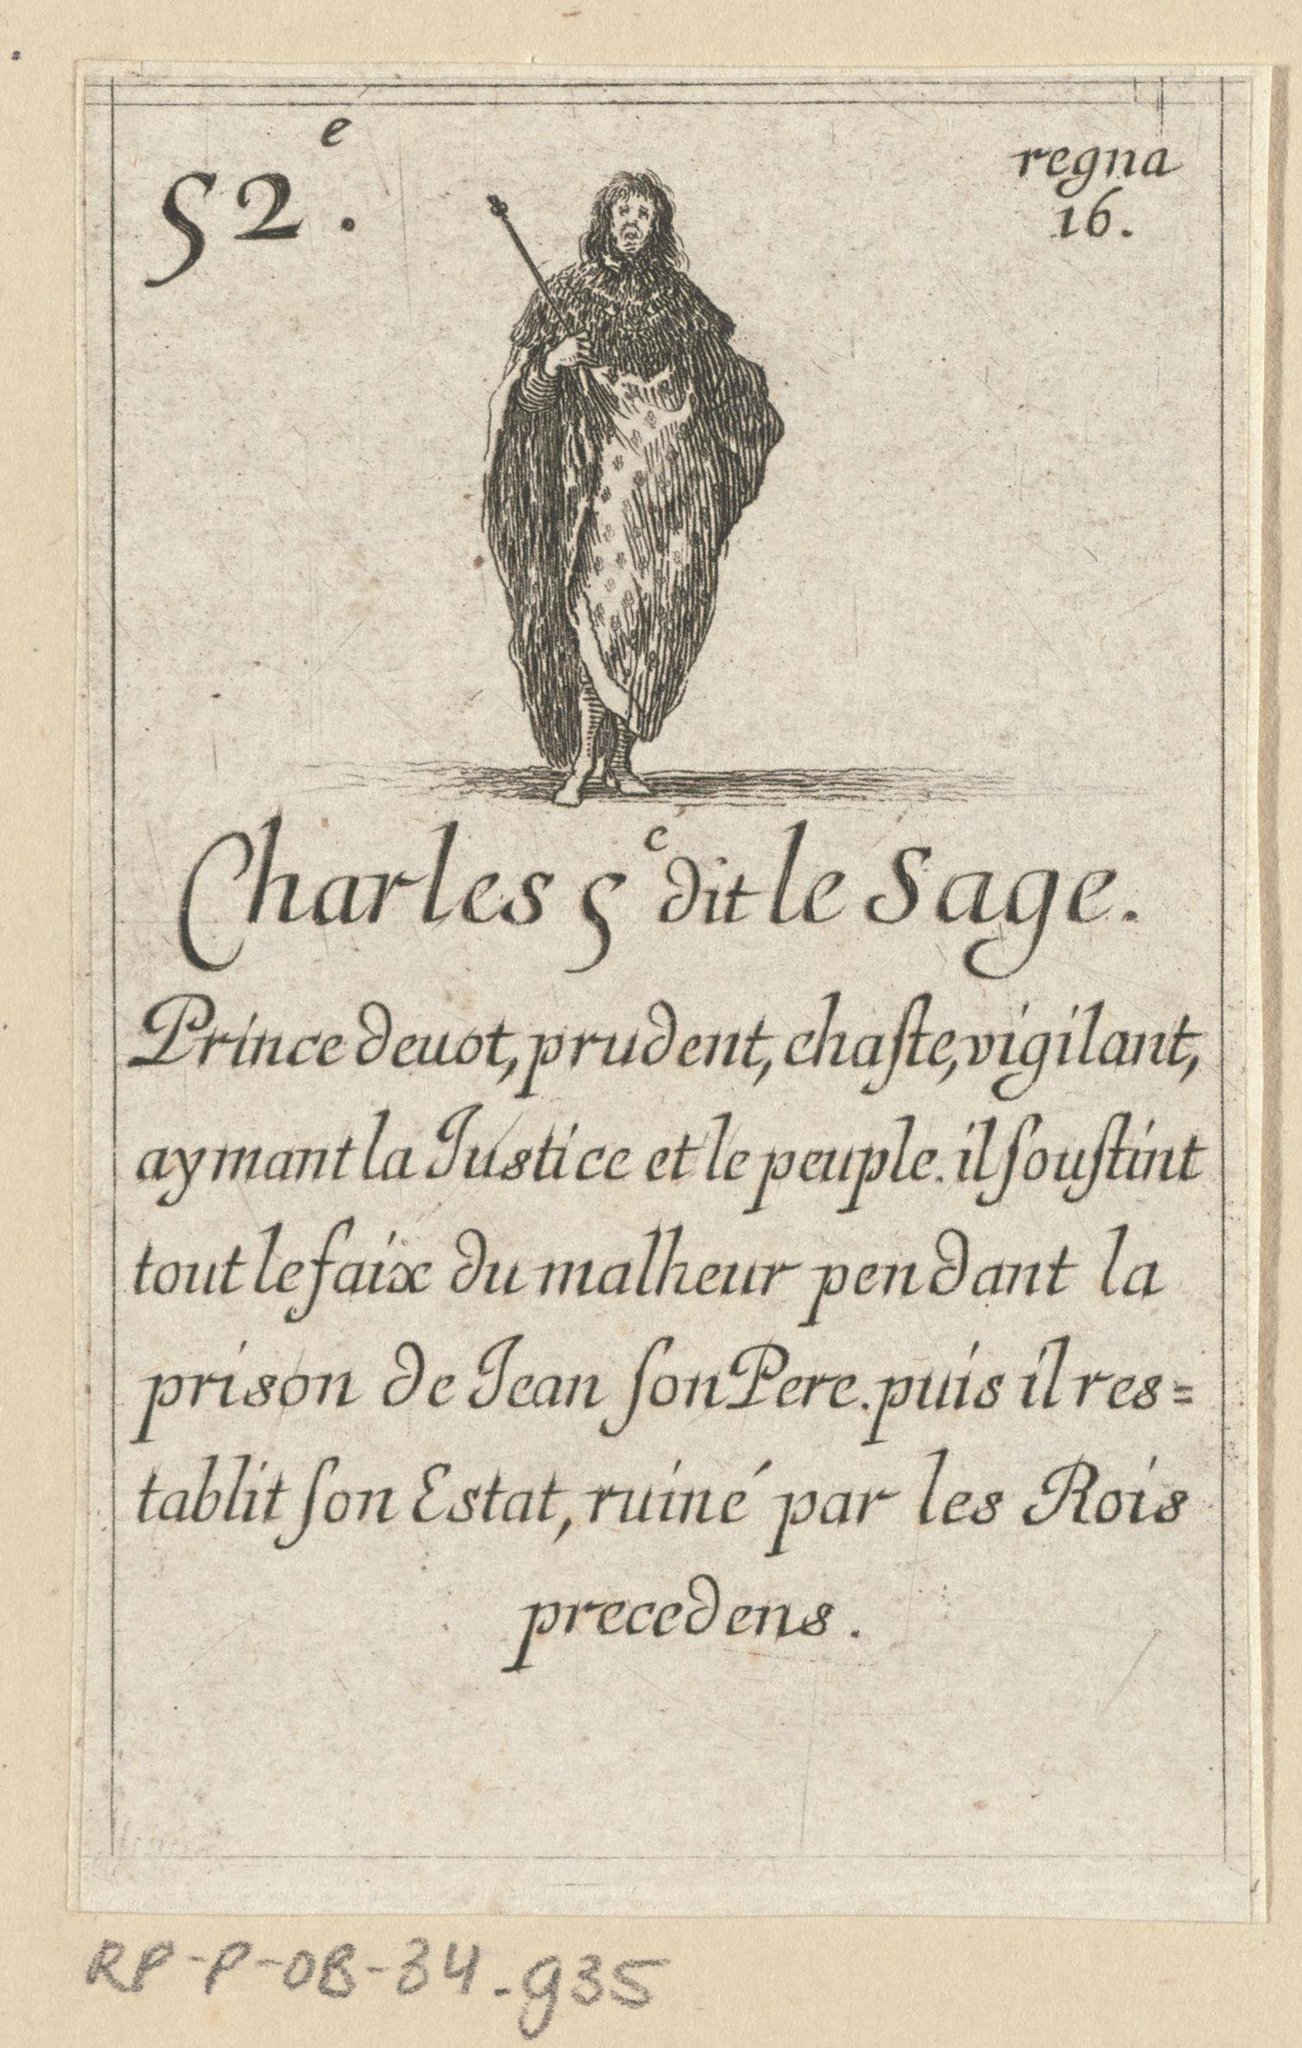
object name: print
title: Charles 5e dit le Sage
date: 1620-1664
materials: paper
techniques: etching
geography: paris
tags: paris, ruler, sovereign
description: Deze prent maakt deel uit van een kaartspel met 39 kaarten met voorstellingen van Franse koningen. De serie is uitgedacht door Jean Desmarests de Saint-Sorlin in opdracht van Kardinaal Mazarin. Het kaartspel werd gemaakt voor de jonge Lodewijk XIV, samen met het Jeu des Fables, Jeu des Reynes Renommées en Jeu de la géographie.